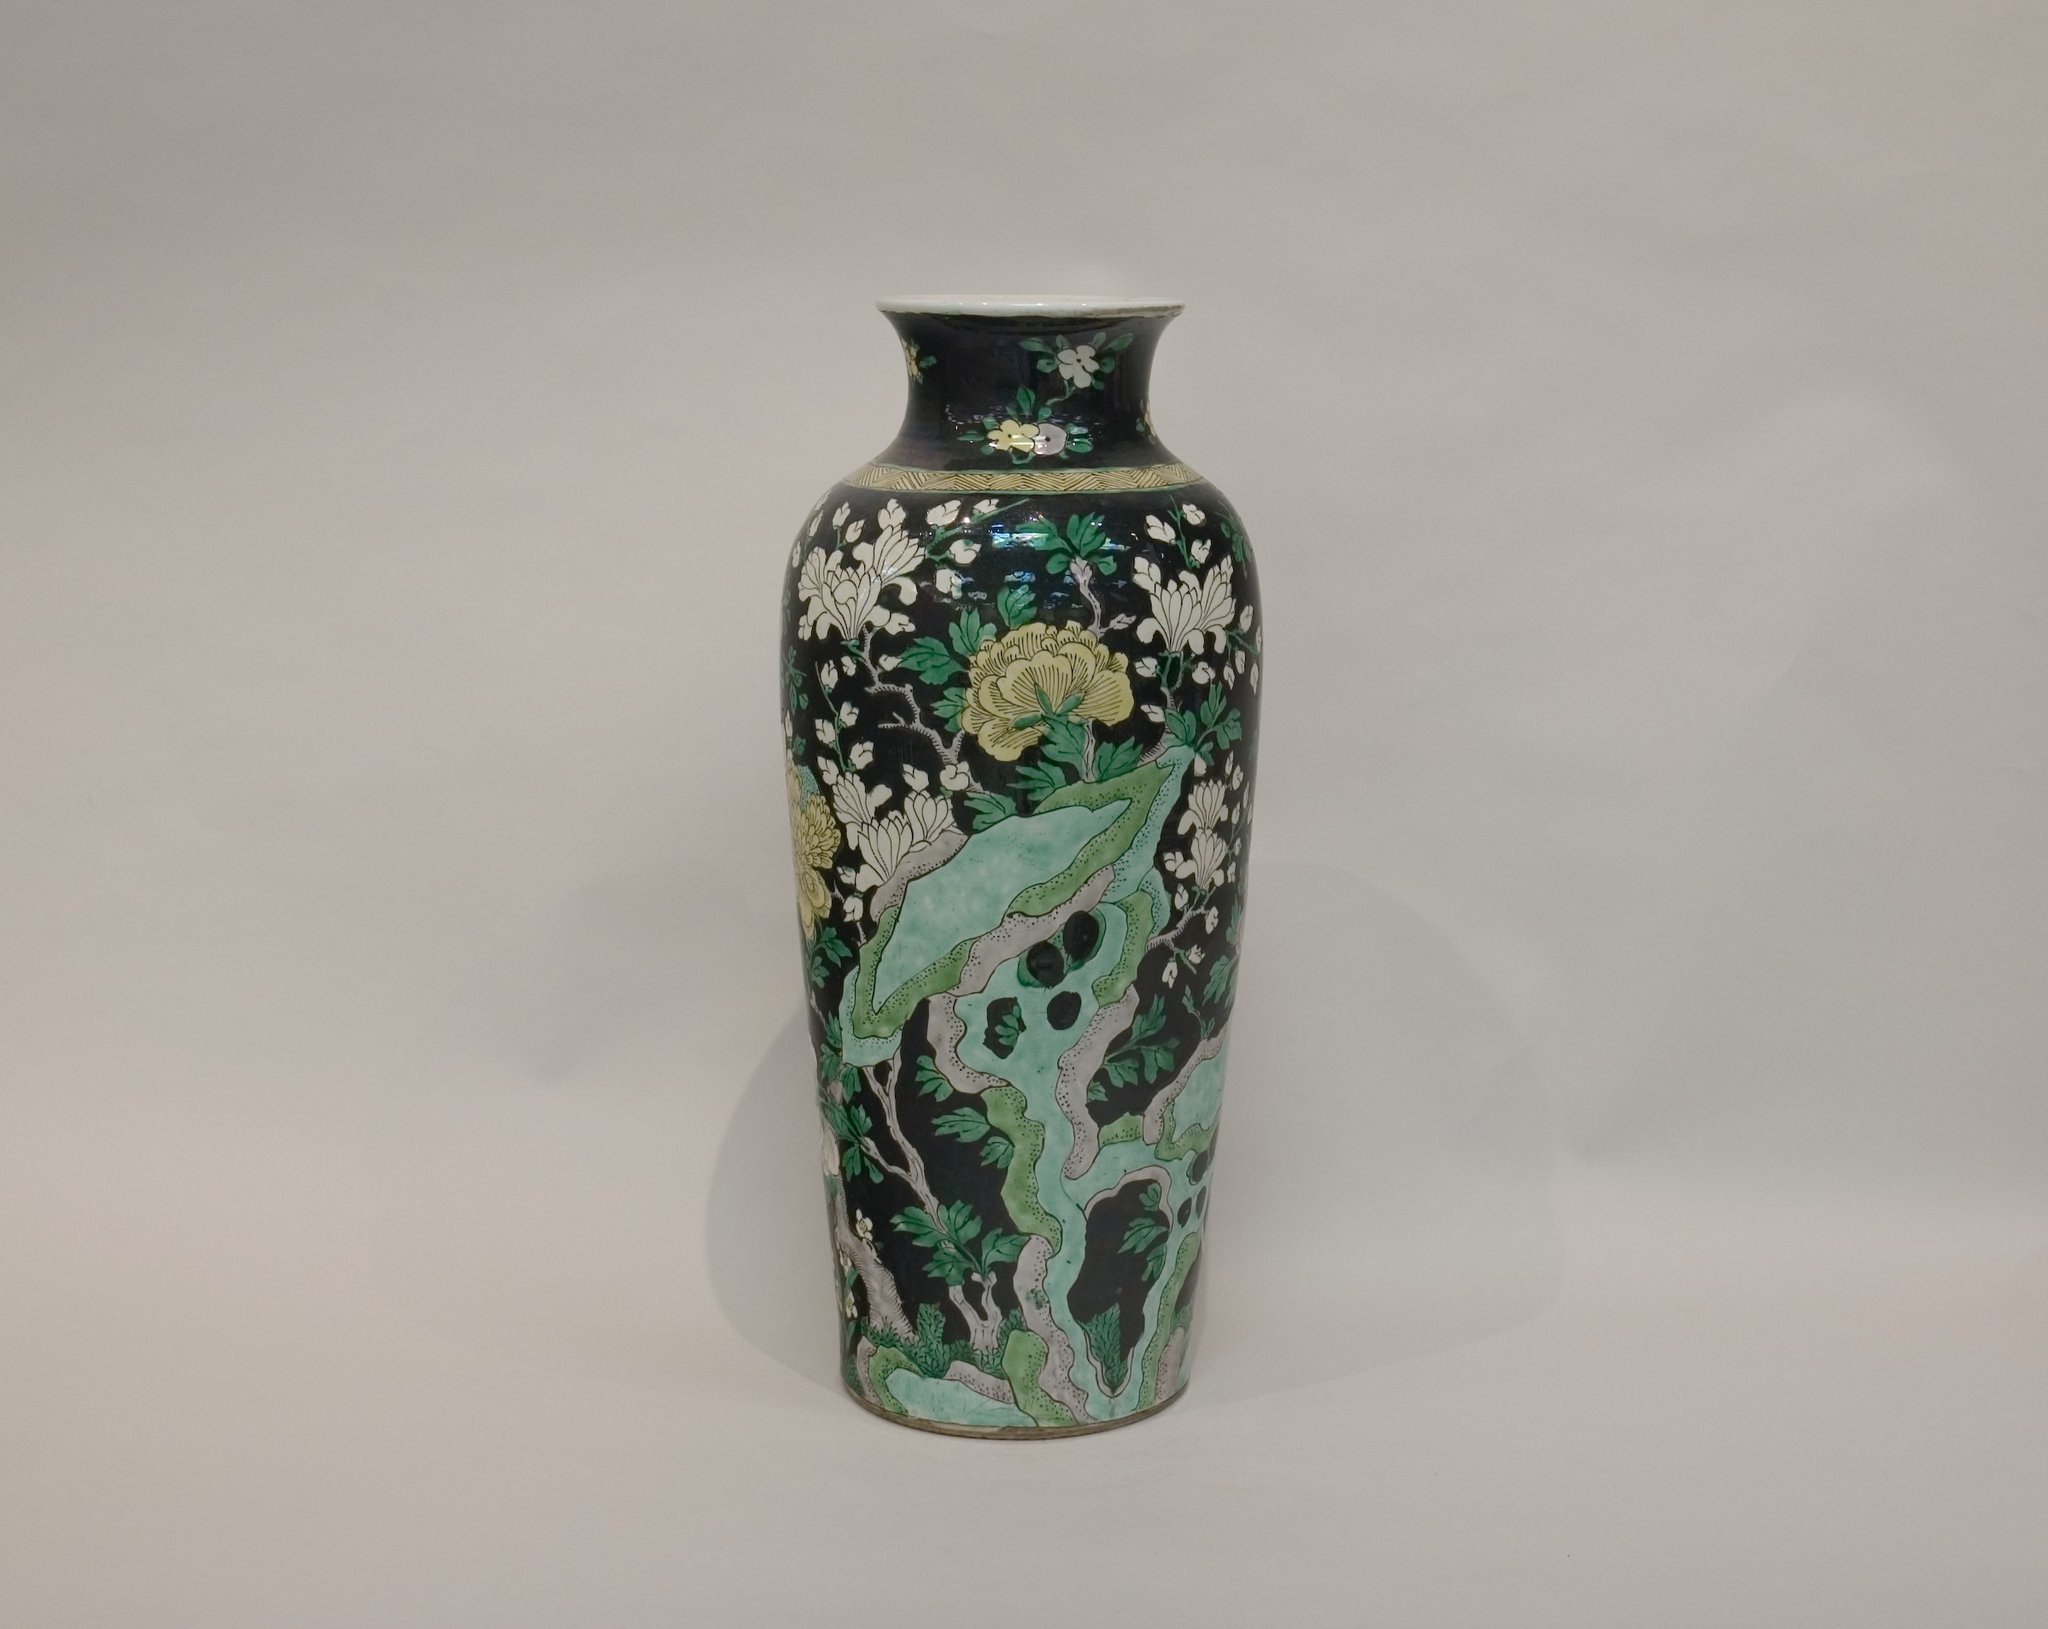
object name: vase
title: Vase with flower and rock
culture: chinese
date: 1801-1900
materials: enamel, porcelain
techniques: overglaze, painting, polychrome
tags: flowers